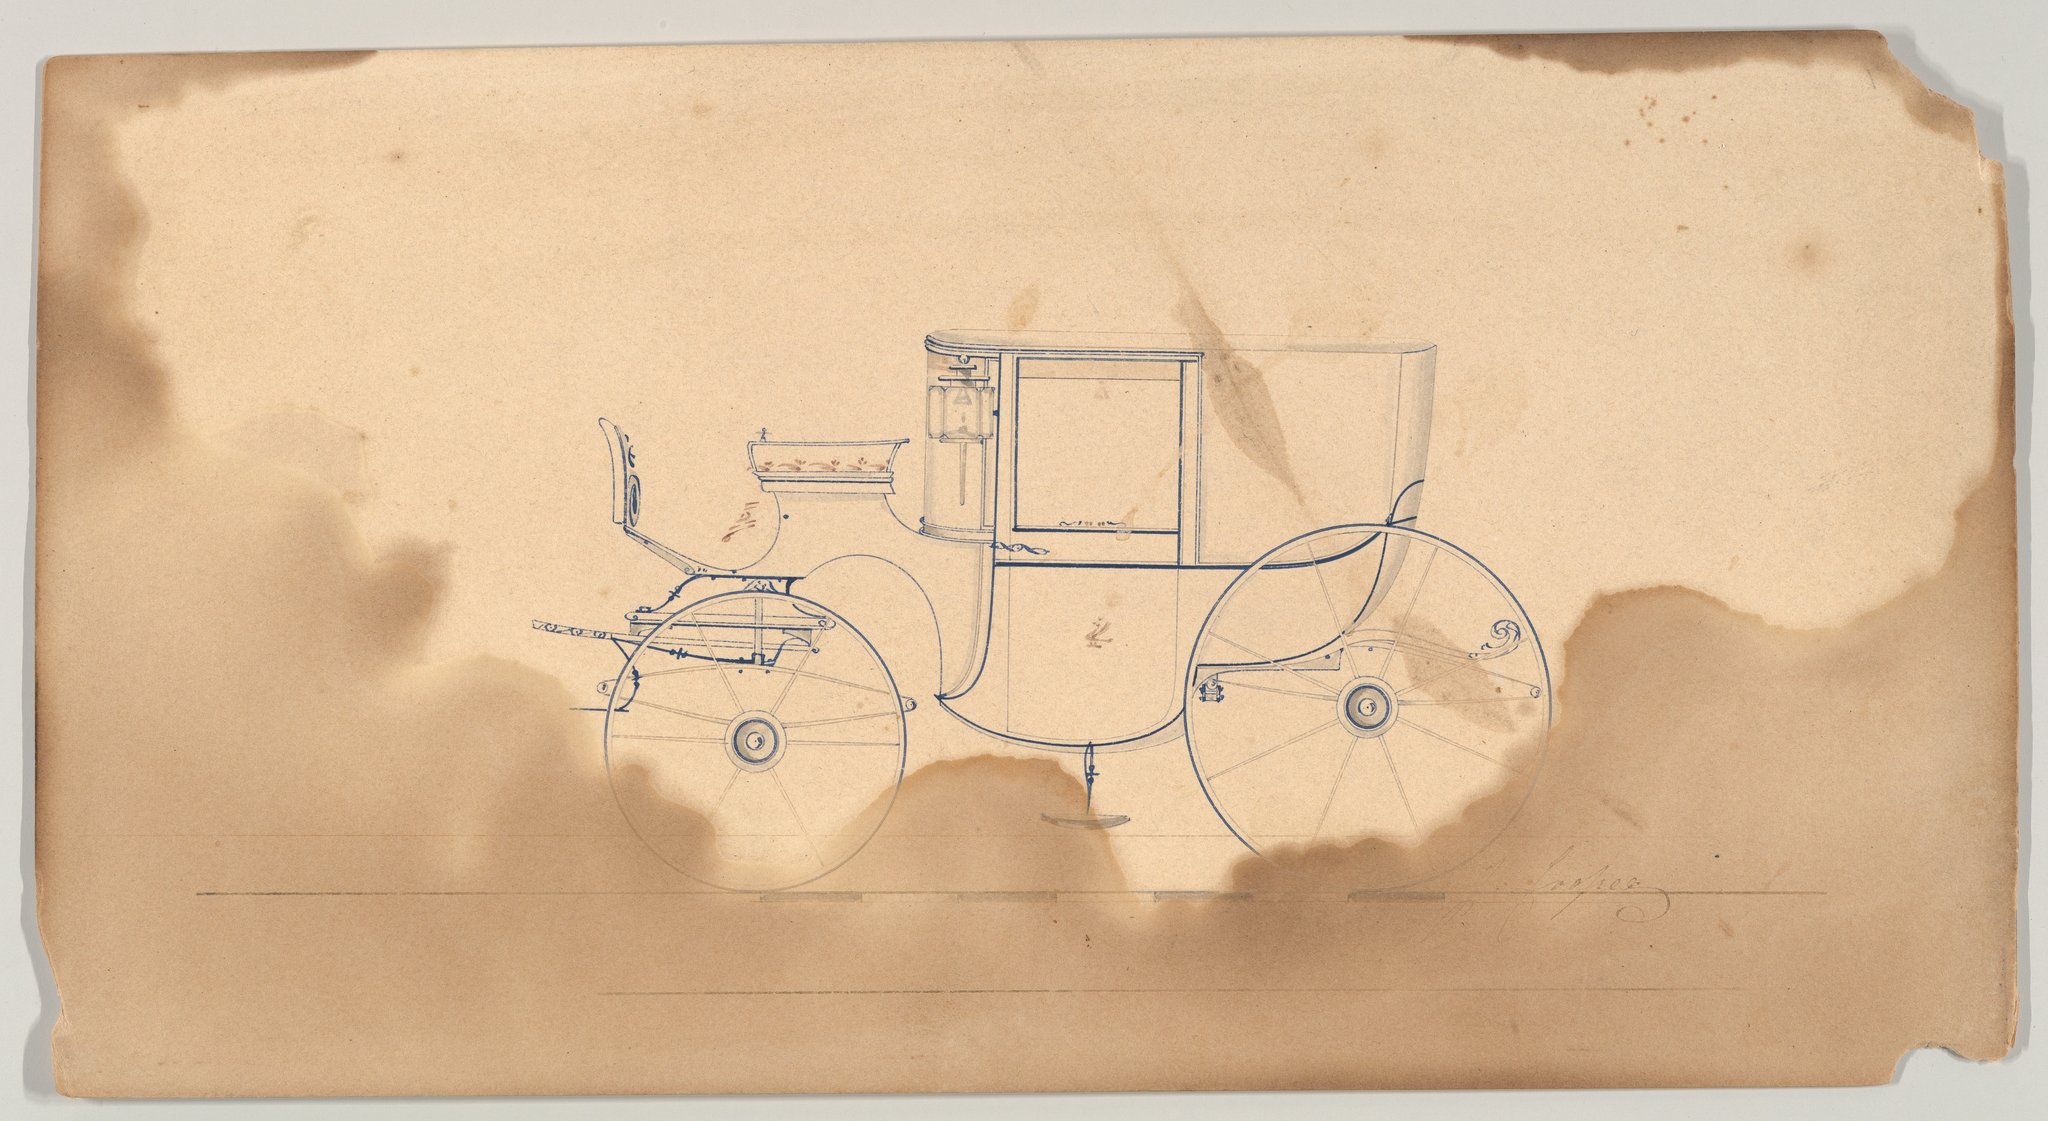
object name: drawing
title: Coupé (unnumbered)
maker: brewster & co.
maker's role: manufacturer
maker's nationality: american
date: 1850-1870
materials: watercolor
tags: carriages